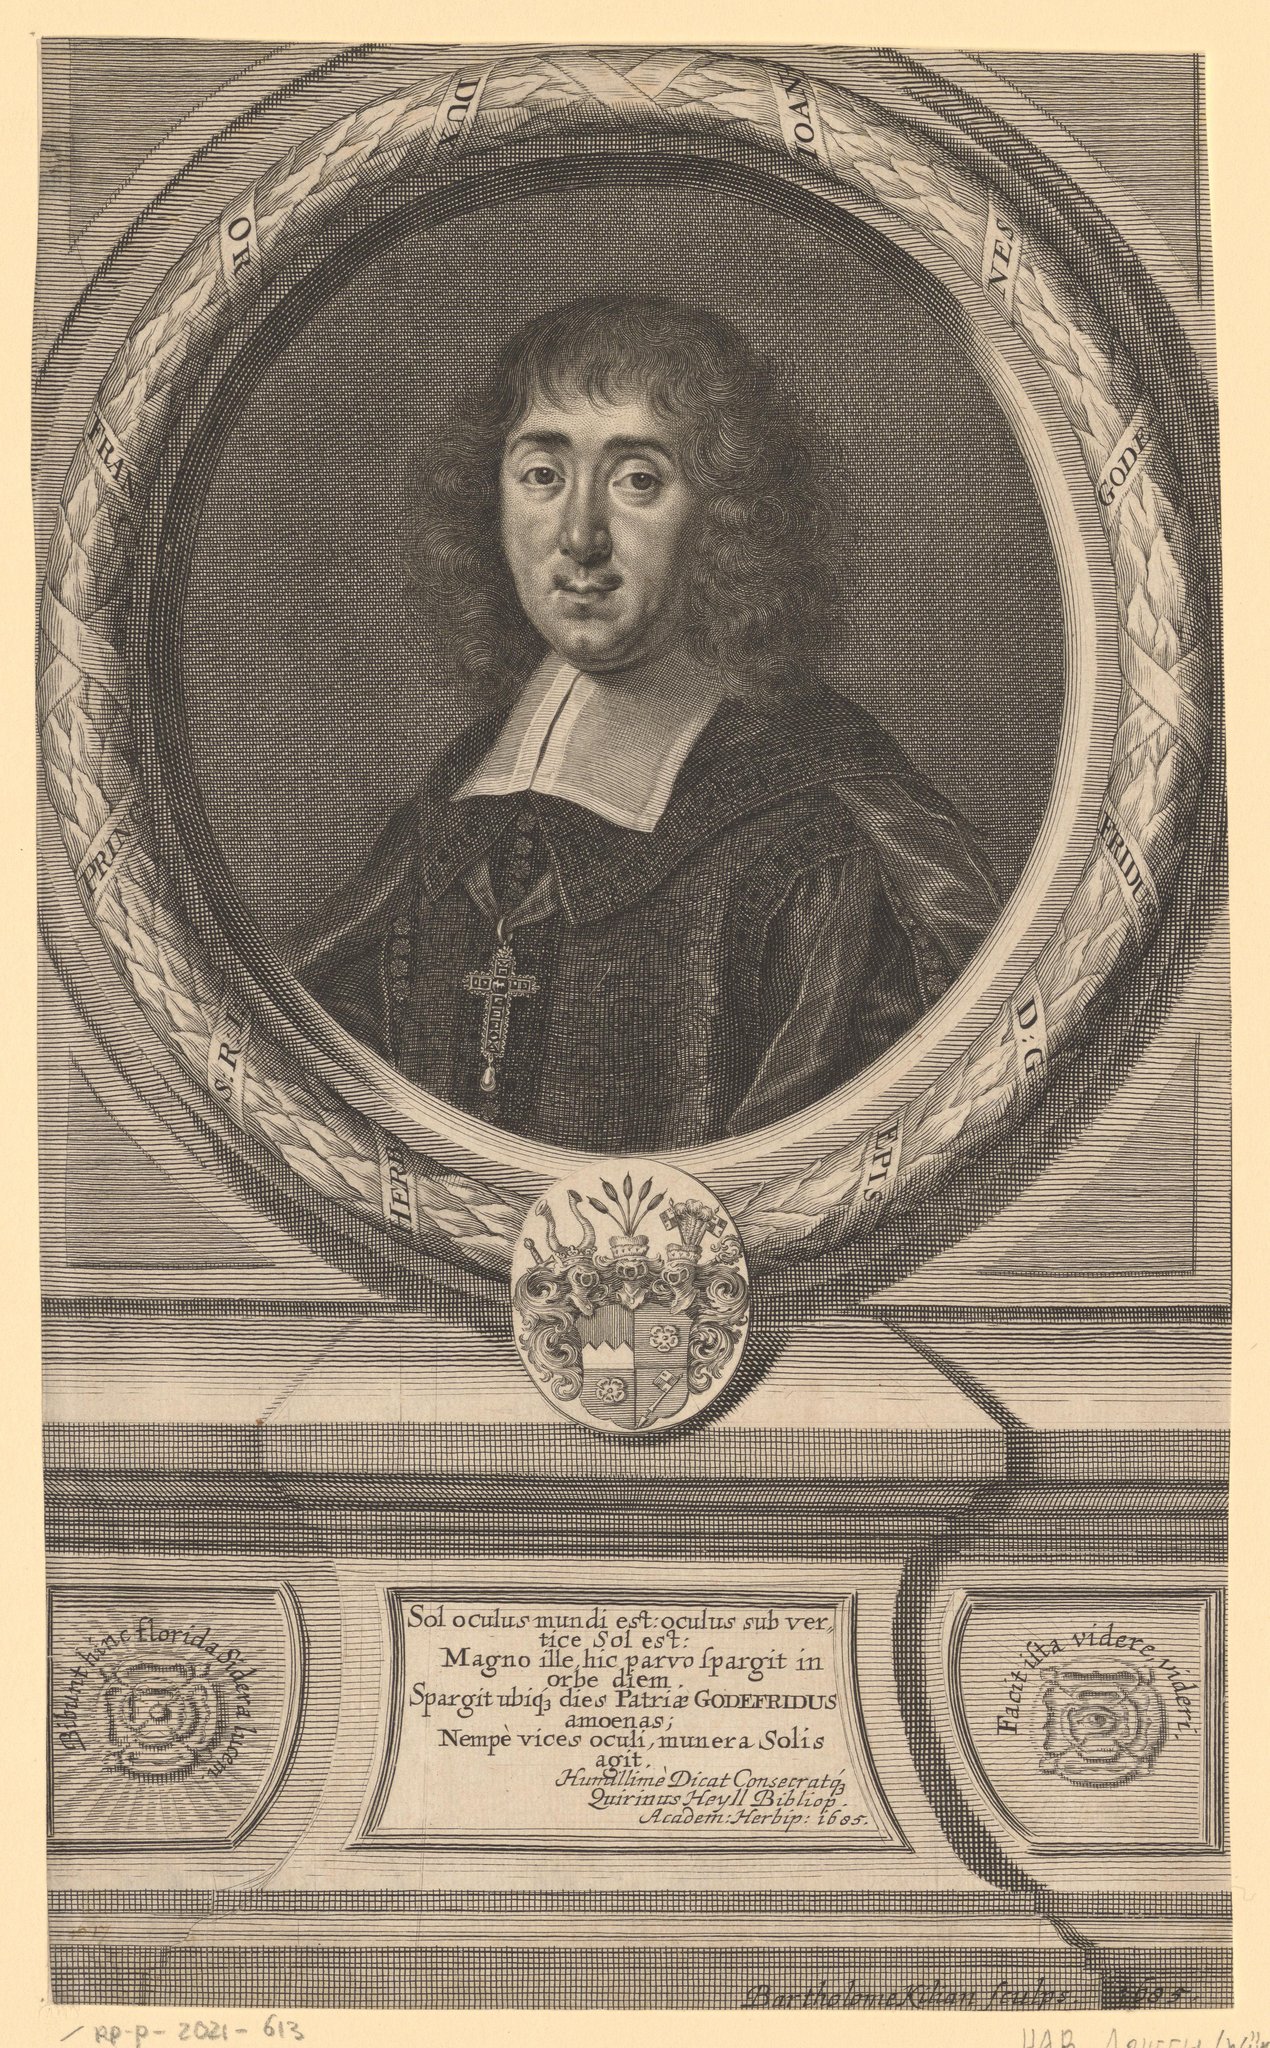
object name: print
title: Portret van Johann Gottfried II von Guttenberg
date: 1685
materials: paper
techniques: engraving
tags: johann gottfried von guttenberg, theologian, historical persons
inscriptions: date